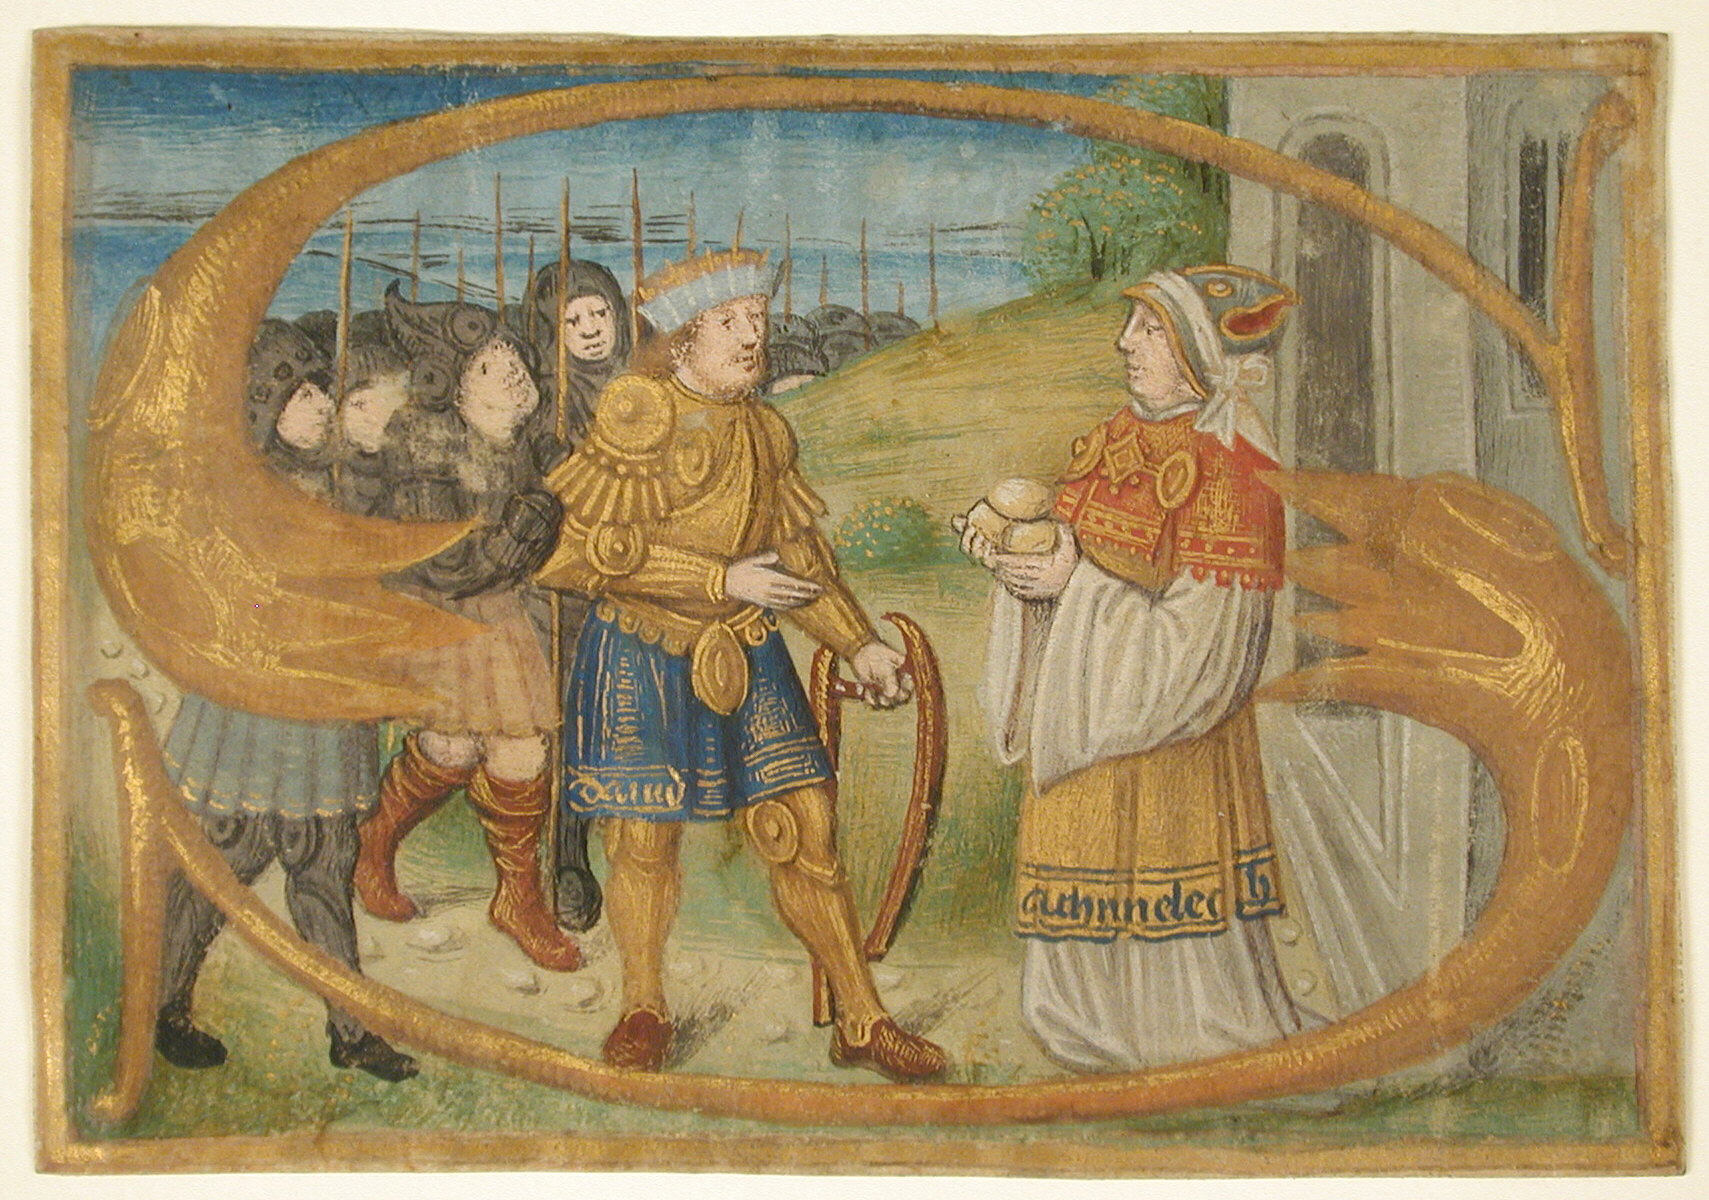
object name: manuscript leaf cutting from a missal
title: Manuscript Leaf Cutting Probably from a Missal with an Illuminated Initial S and King David Receiving the Holy Bread from Ahimelech the Priest.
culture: french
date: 1467-1500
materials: ink, metal leaf, parchment, paint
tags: men,women